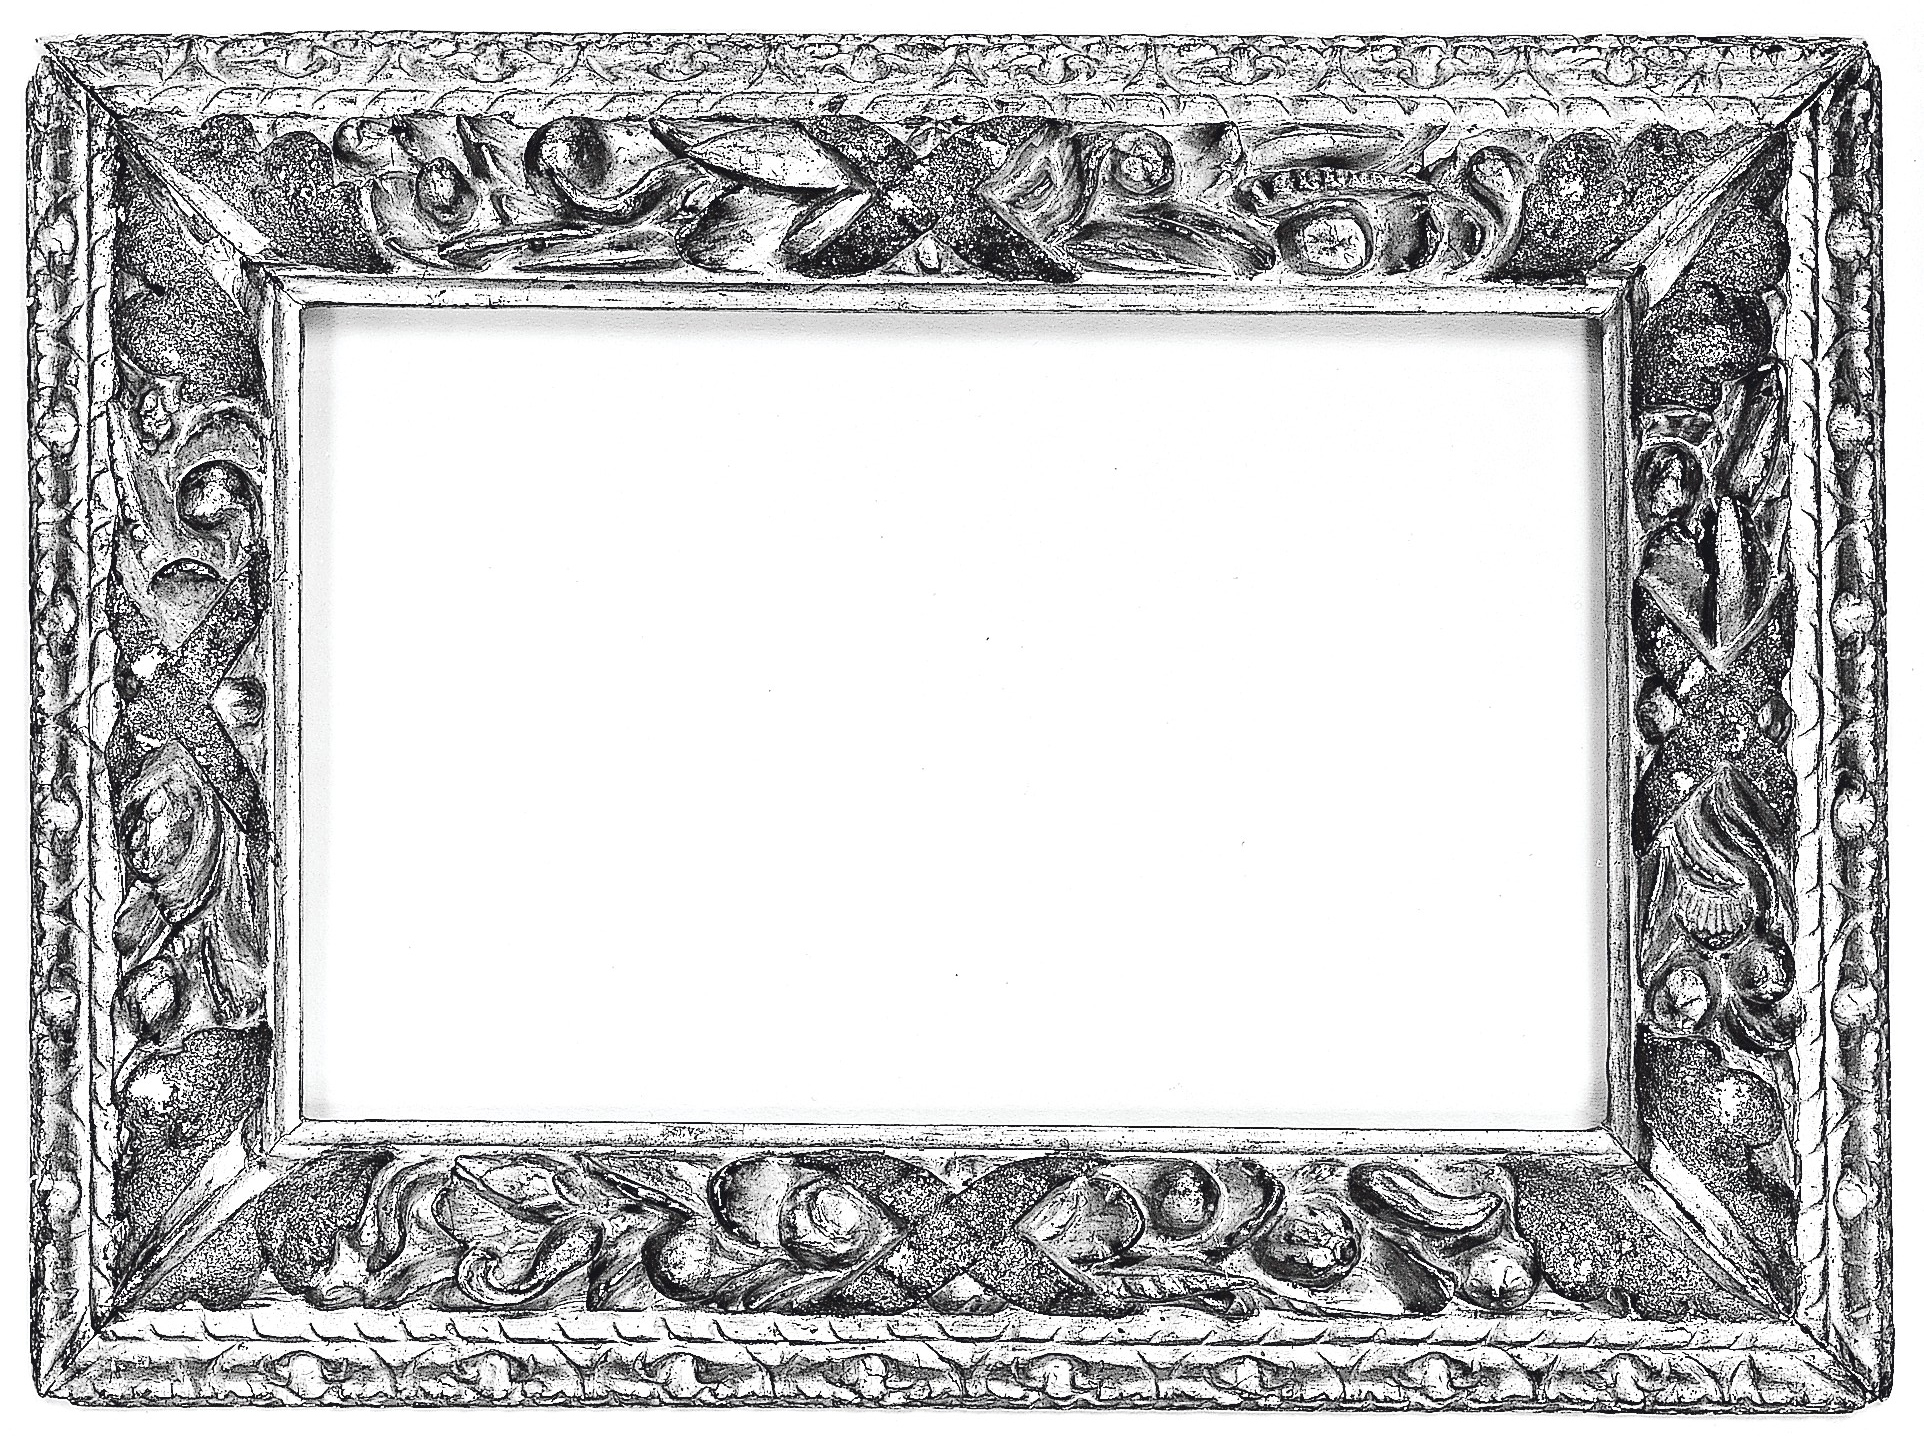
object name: frame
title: Wreath frame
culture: italian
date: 1567-1600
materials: wood